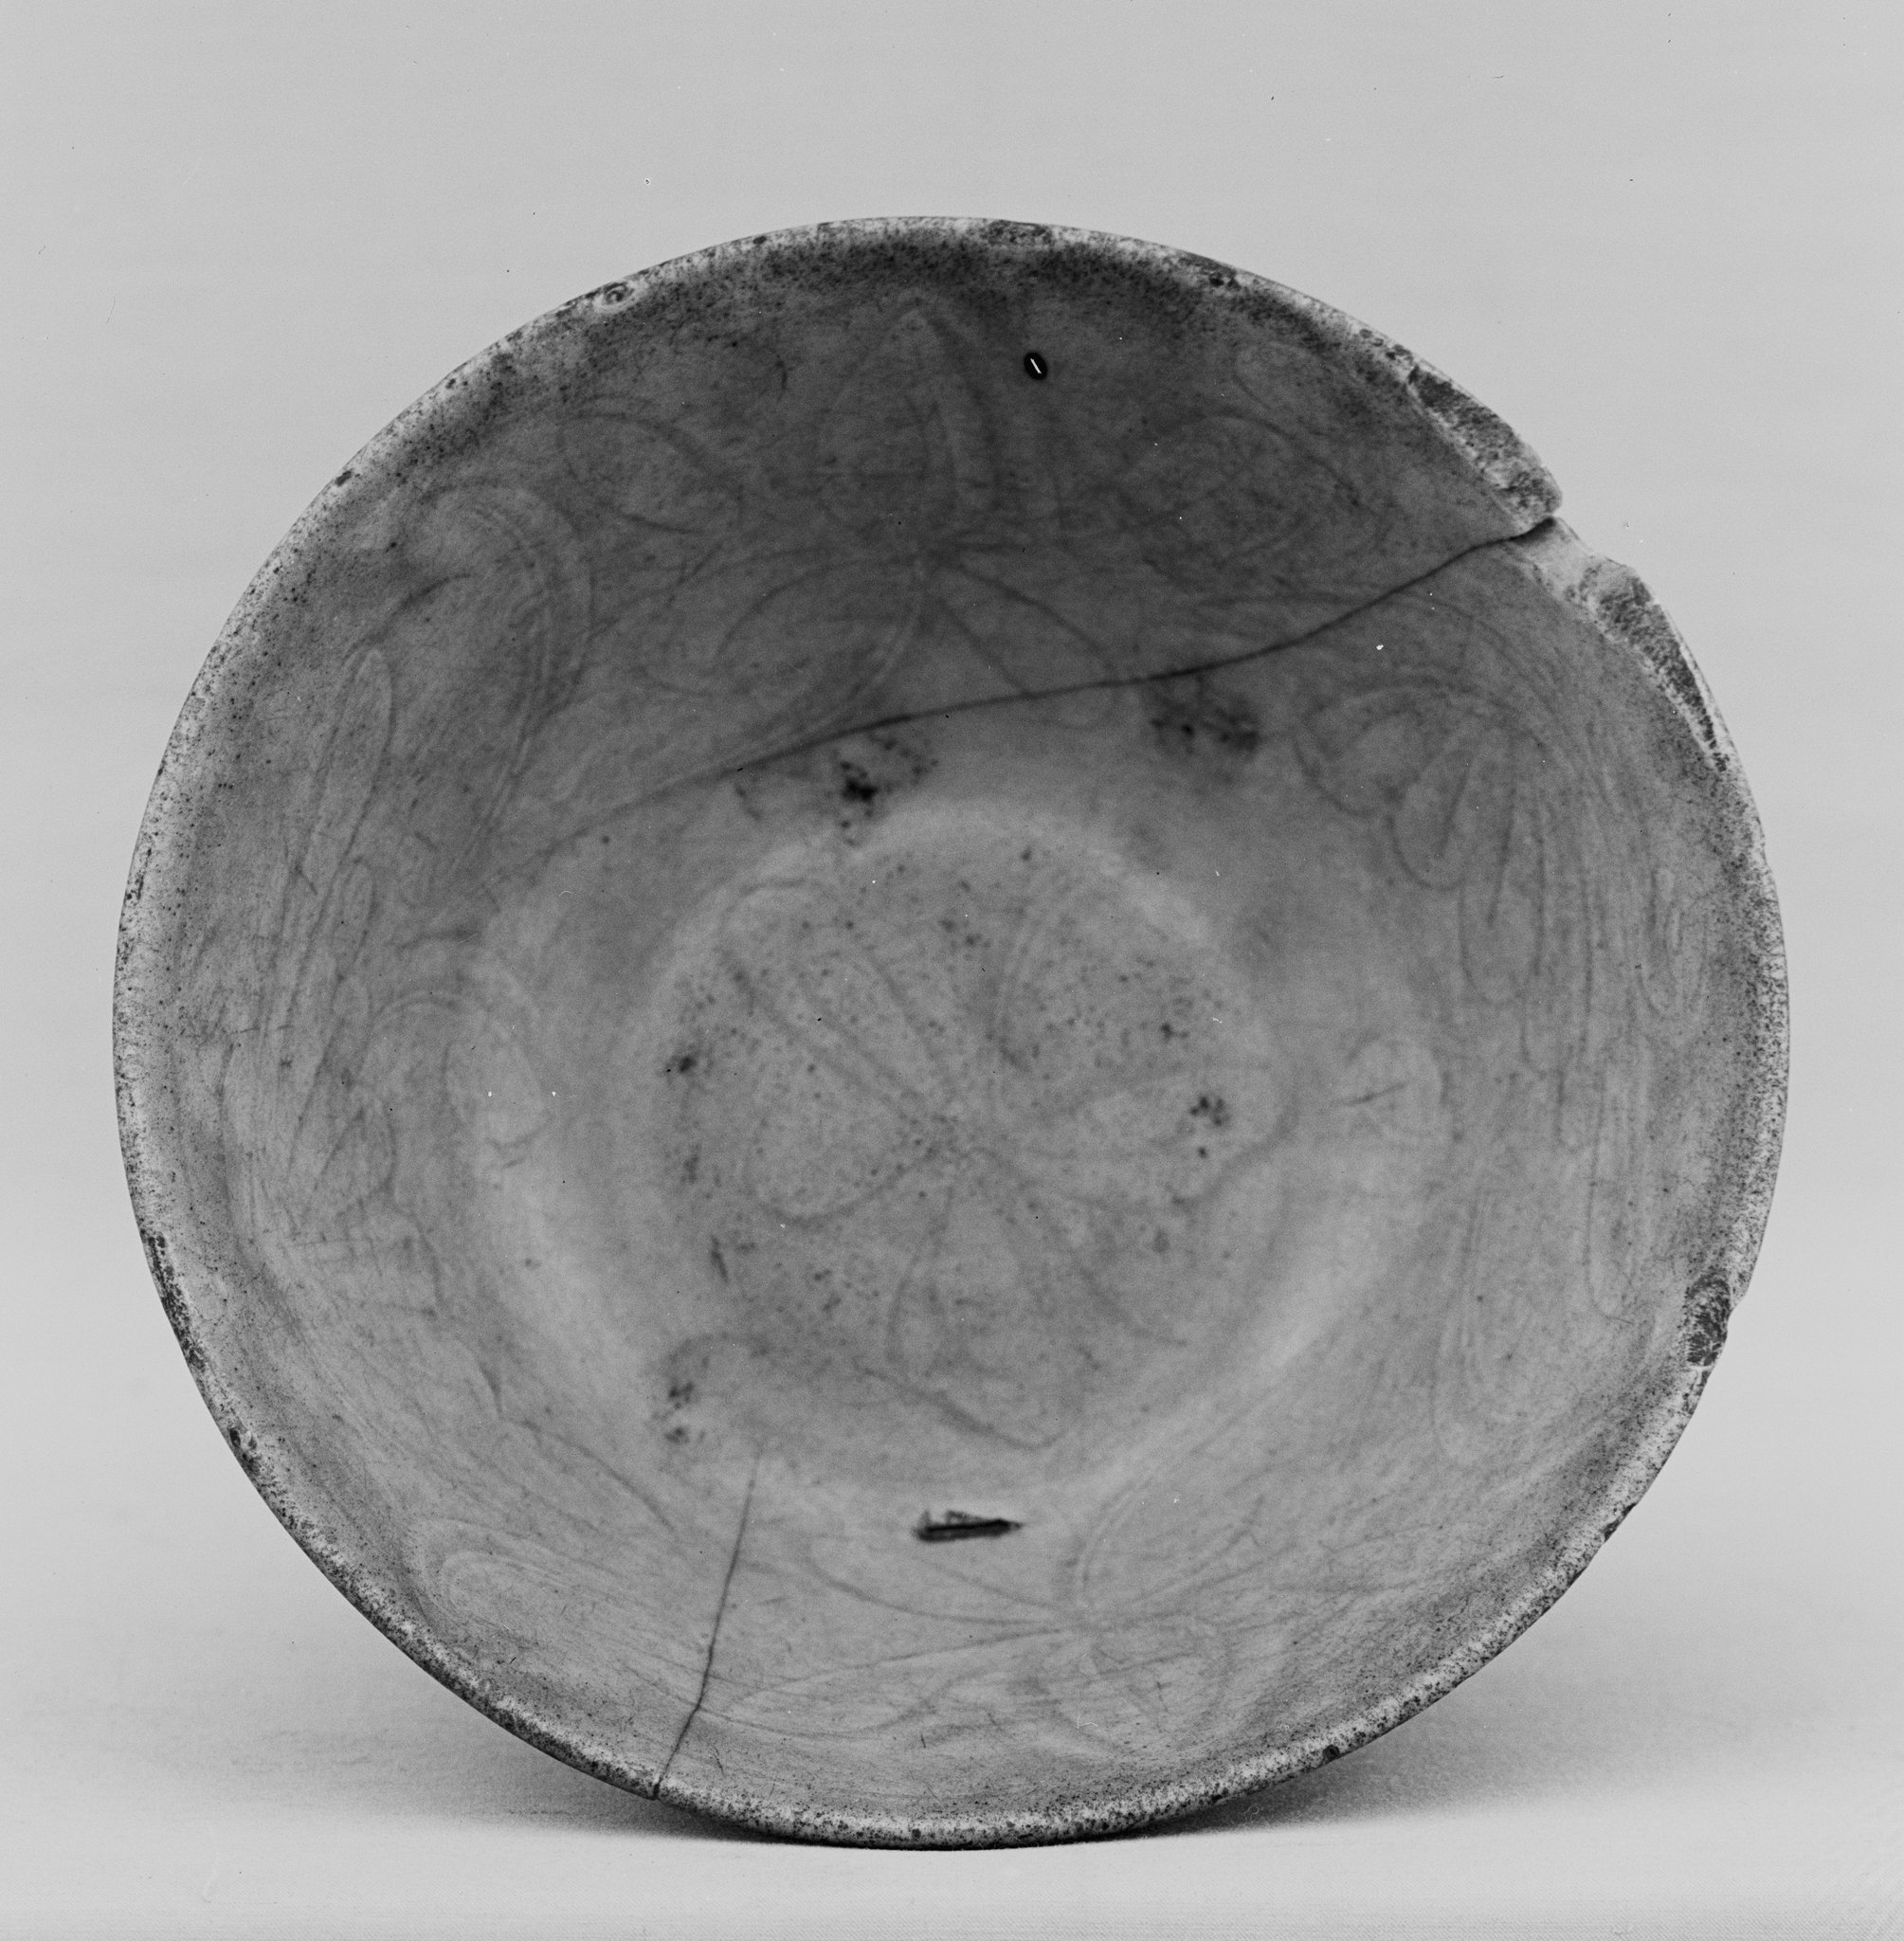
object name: bowl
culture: chinese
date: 1801-1900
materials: ceramic glaze, glaze, stoneware